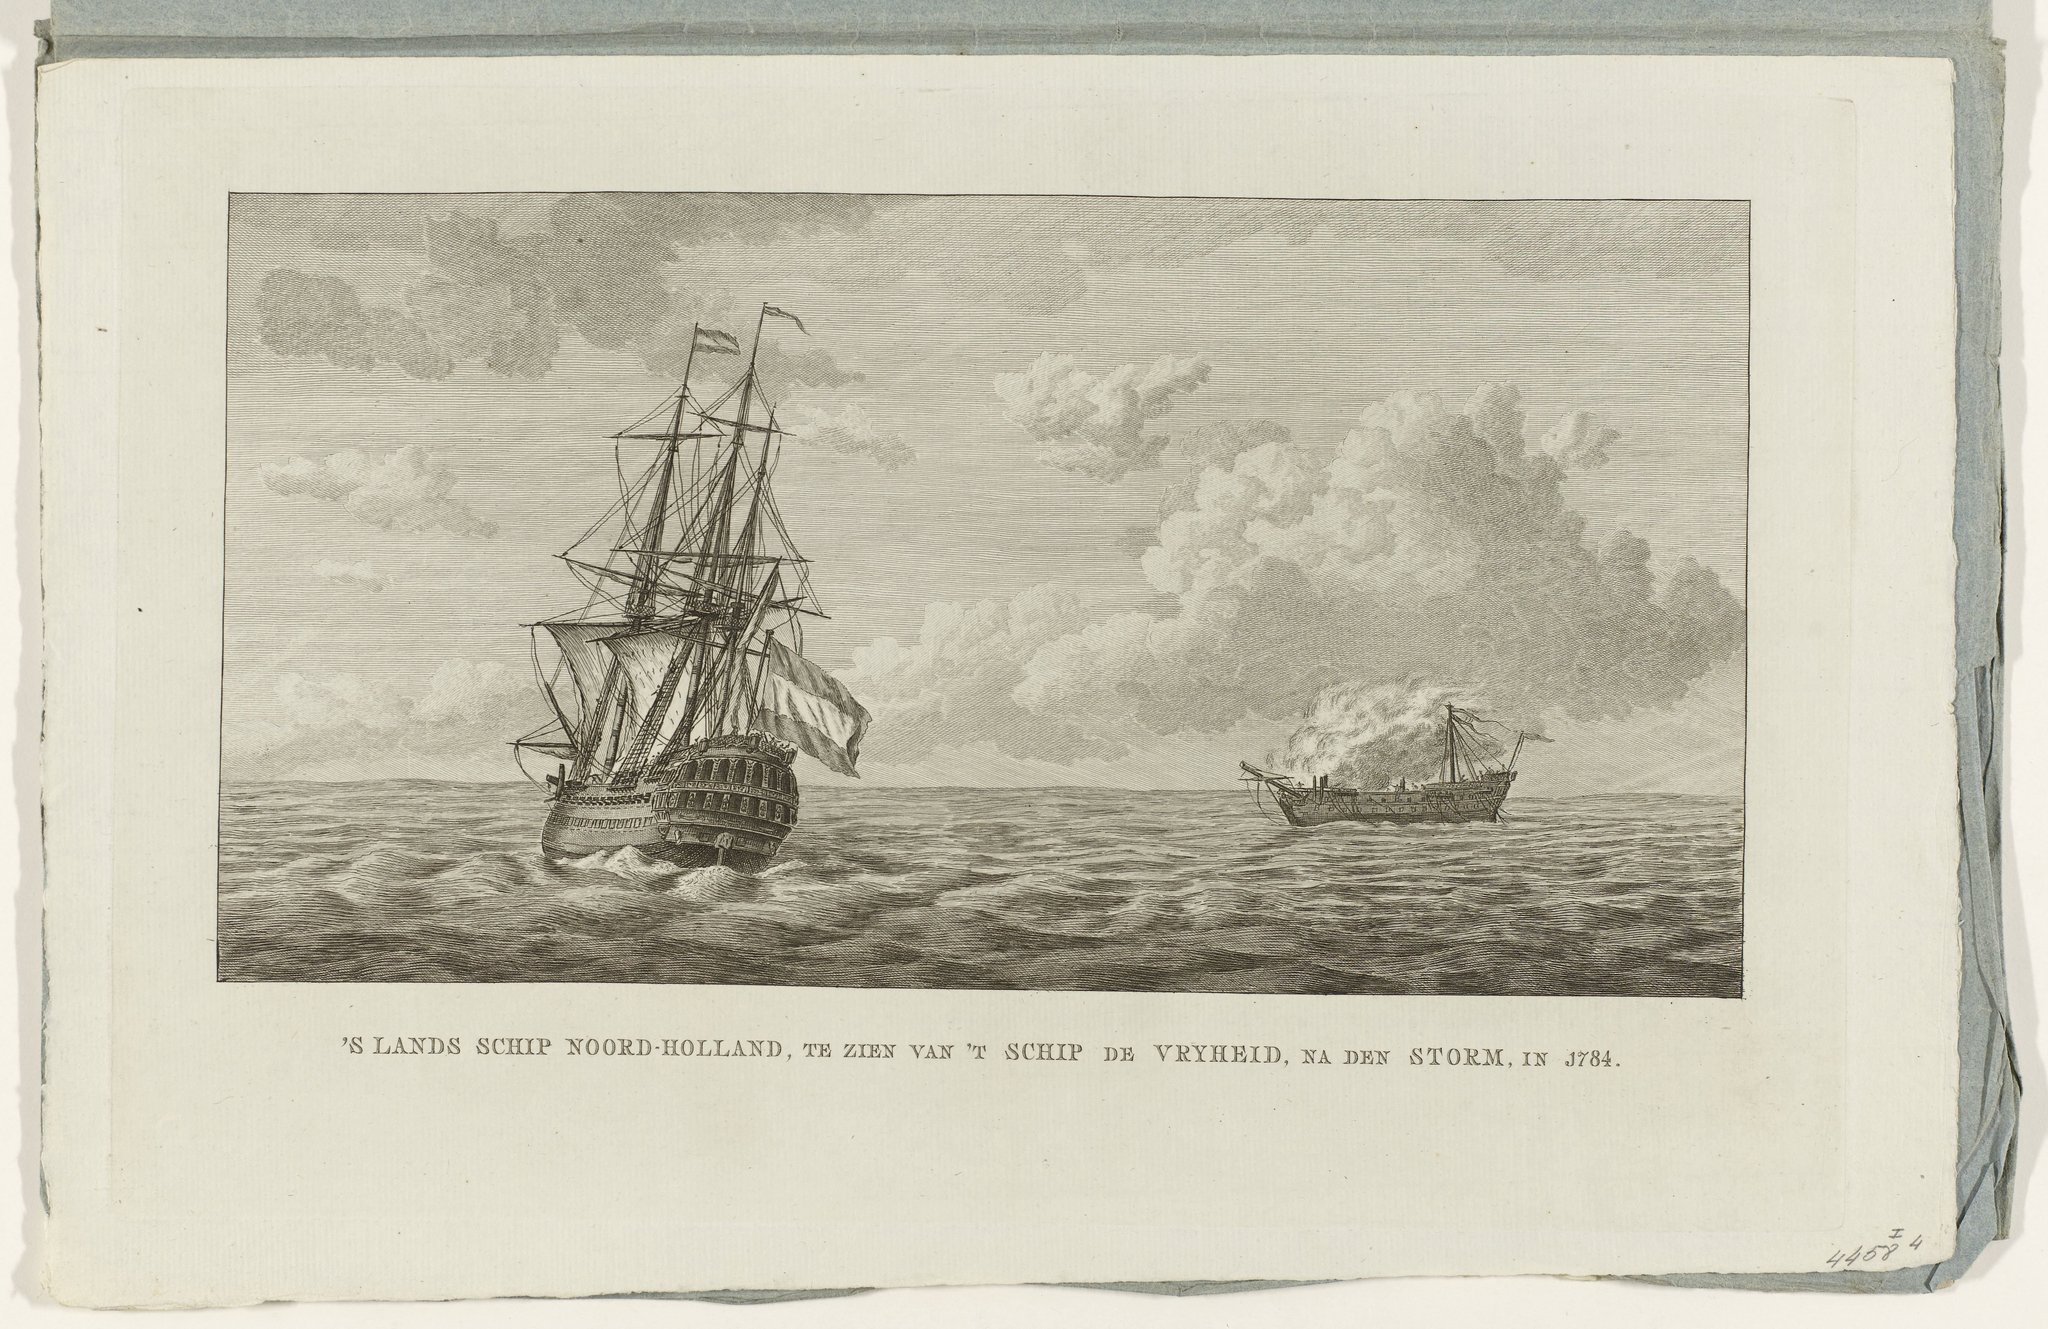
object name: print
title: Map met vier platen van historische gebeurtenissen ter zee in de jaren 1782-1784, eerste serie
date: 1784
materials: paper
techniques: engraving, etching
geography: amsterdam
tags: shipwreck (+ propulsion of vehicle, ship, etc. by wind)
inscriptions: collector's mark: Lugt 2228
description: Het drijvende wrak van het schip Noord-Holland onder bevel van kapitein Reyneveldt, gered na de storm van 3 februari 1784. Op de voorgrond het schip de Vrijheid. Losse prent in de map met vier prenten van historische gebeurtenissen op zee in de jaren 1782-1784, eerste serie.